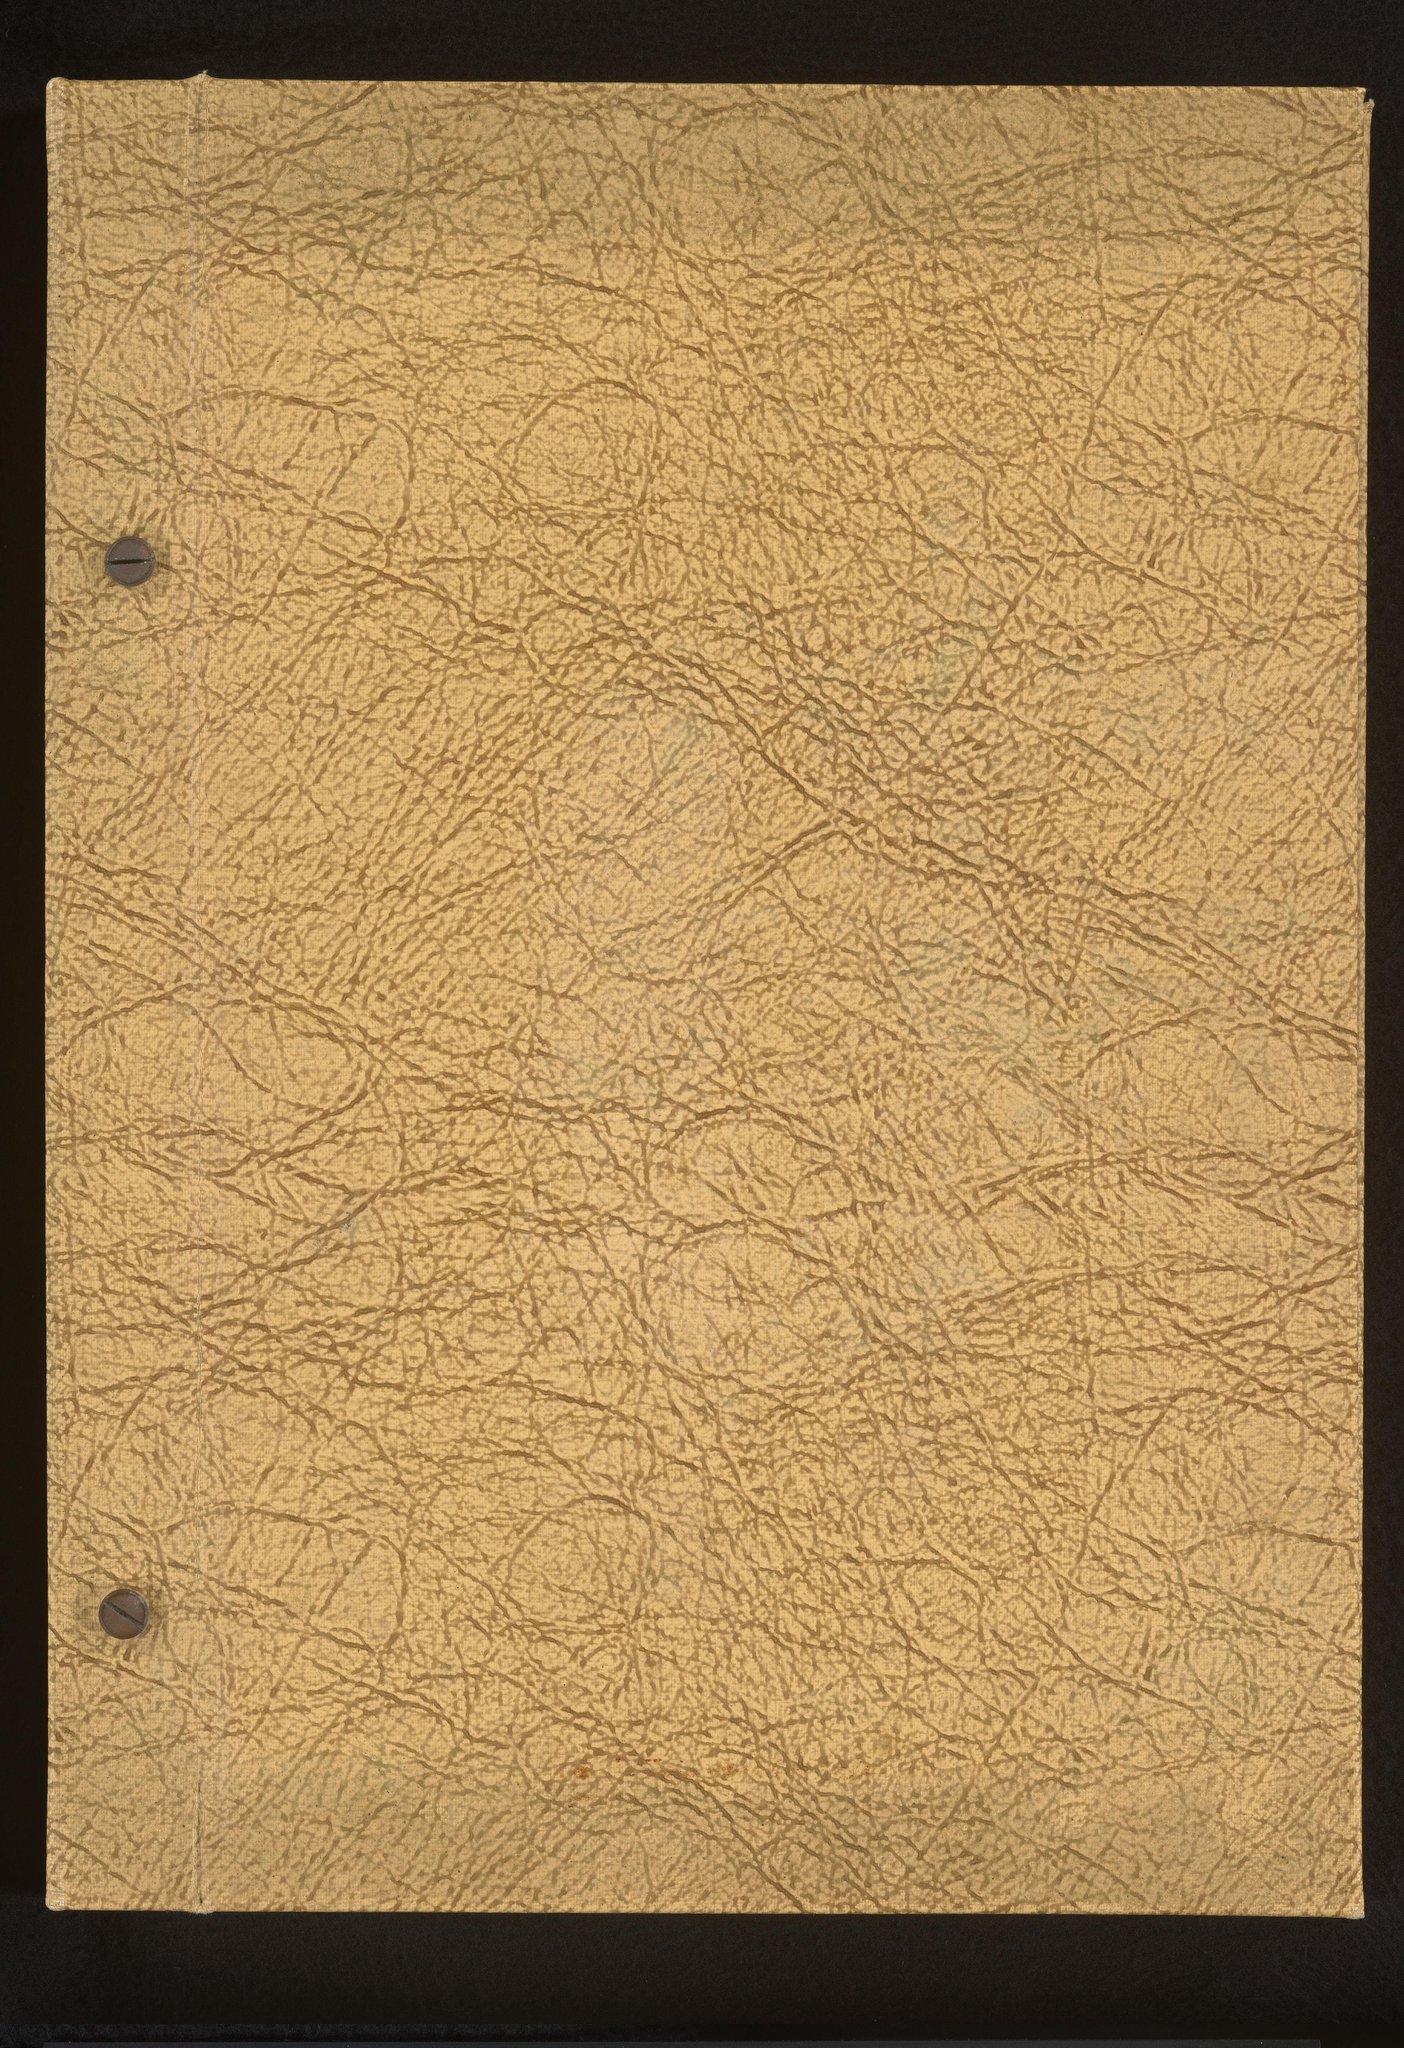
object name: scrapbook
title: Fotoalbum Moengo, Suriname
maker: Anonymous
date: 1927-1931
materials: linen, metal, paper, photographic support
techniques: gelatin silver print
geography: suriname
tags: suriname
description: Fotoalbum met 117 foto's over de bauxietwinning in Moengo en Albina, Suriname. Album in band bekleed met geplastificeerd gewoven stof (linnen) en bedrukt in imitatieleerpatroon in geel en bruin. Het album bevat 27 bladen van zwart karton, bijeengehouden door twee metalen schroeven. De foto's zijn eind jaren twintig, begin jaren dertig genomen en het album is mogelijk samengesteld door de familie Guilonard. Het album geeft niet alleen een beeld van de bauxietwinning maar ook van het koloniale leven aldaar: veel privéfoto's van uitstapjes, bezoeken aan dorpen in het binnenland, jachtpartijen, woonsituaties en huwelijken.